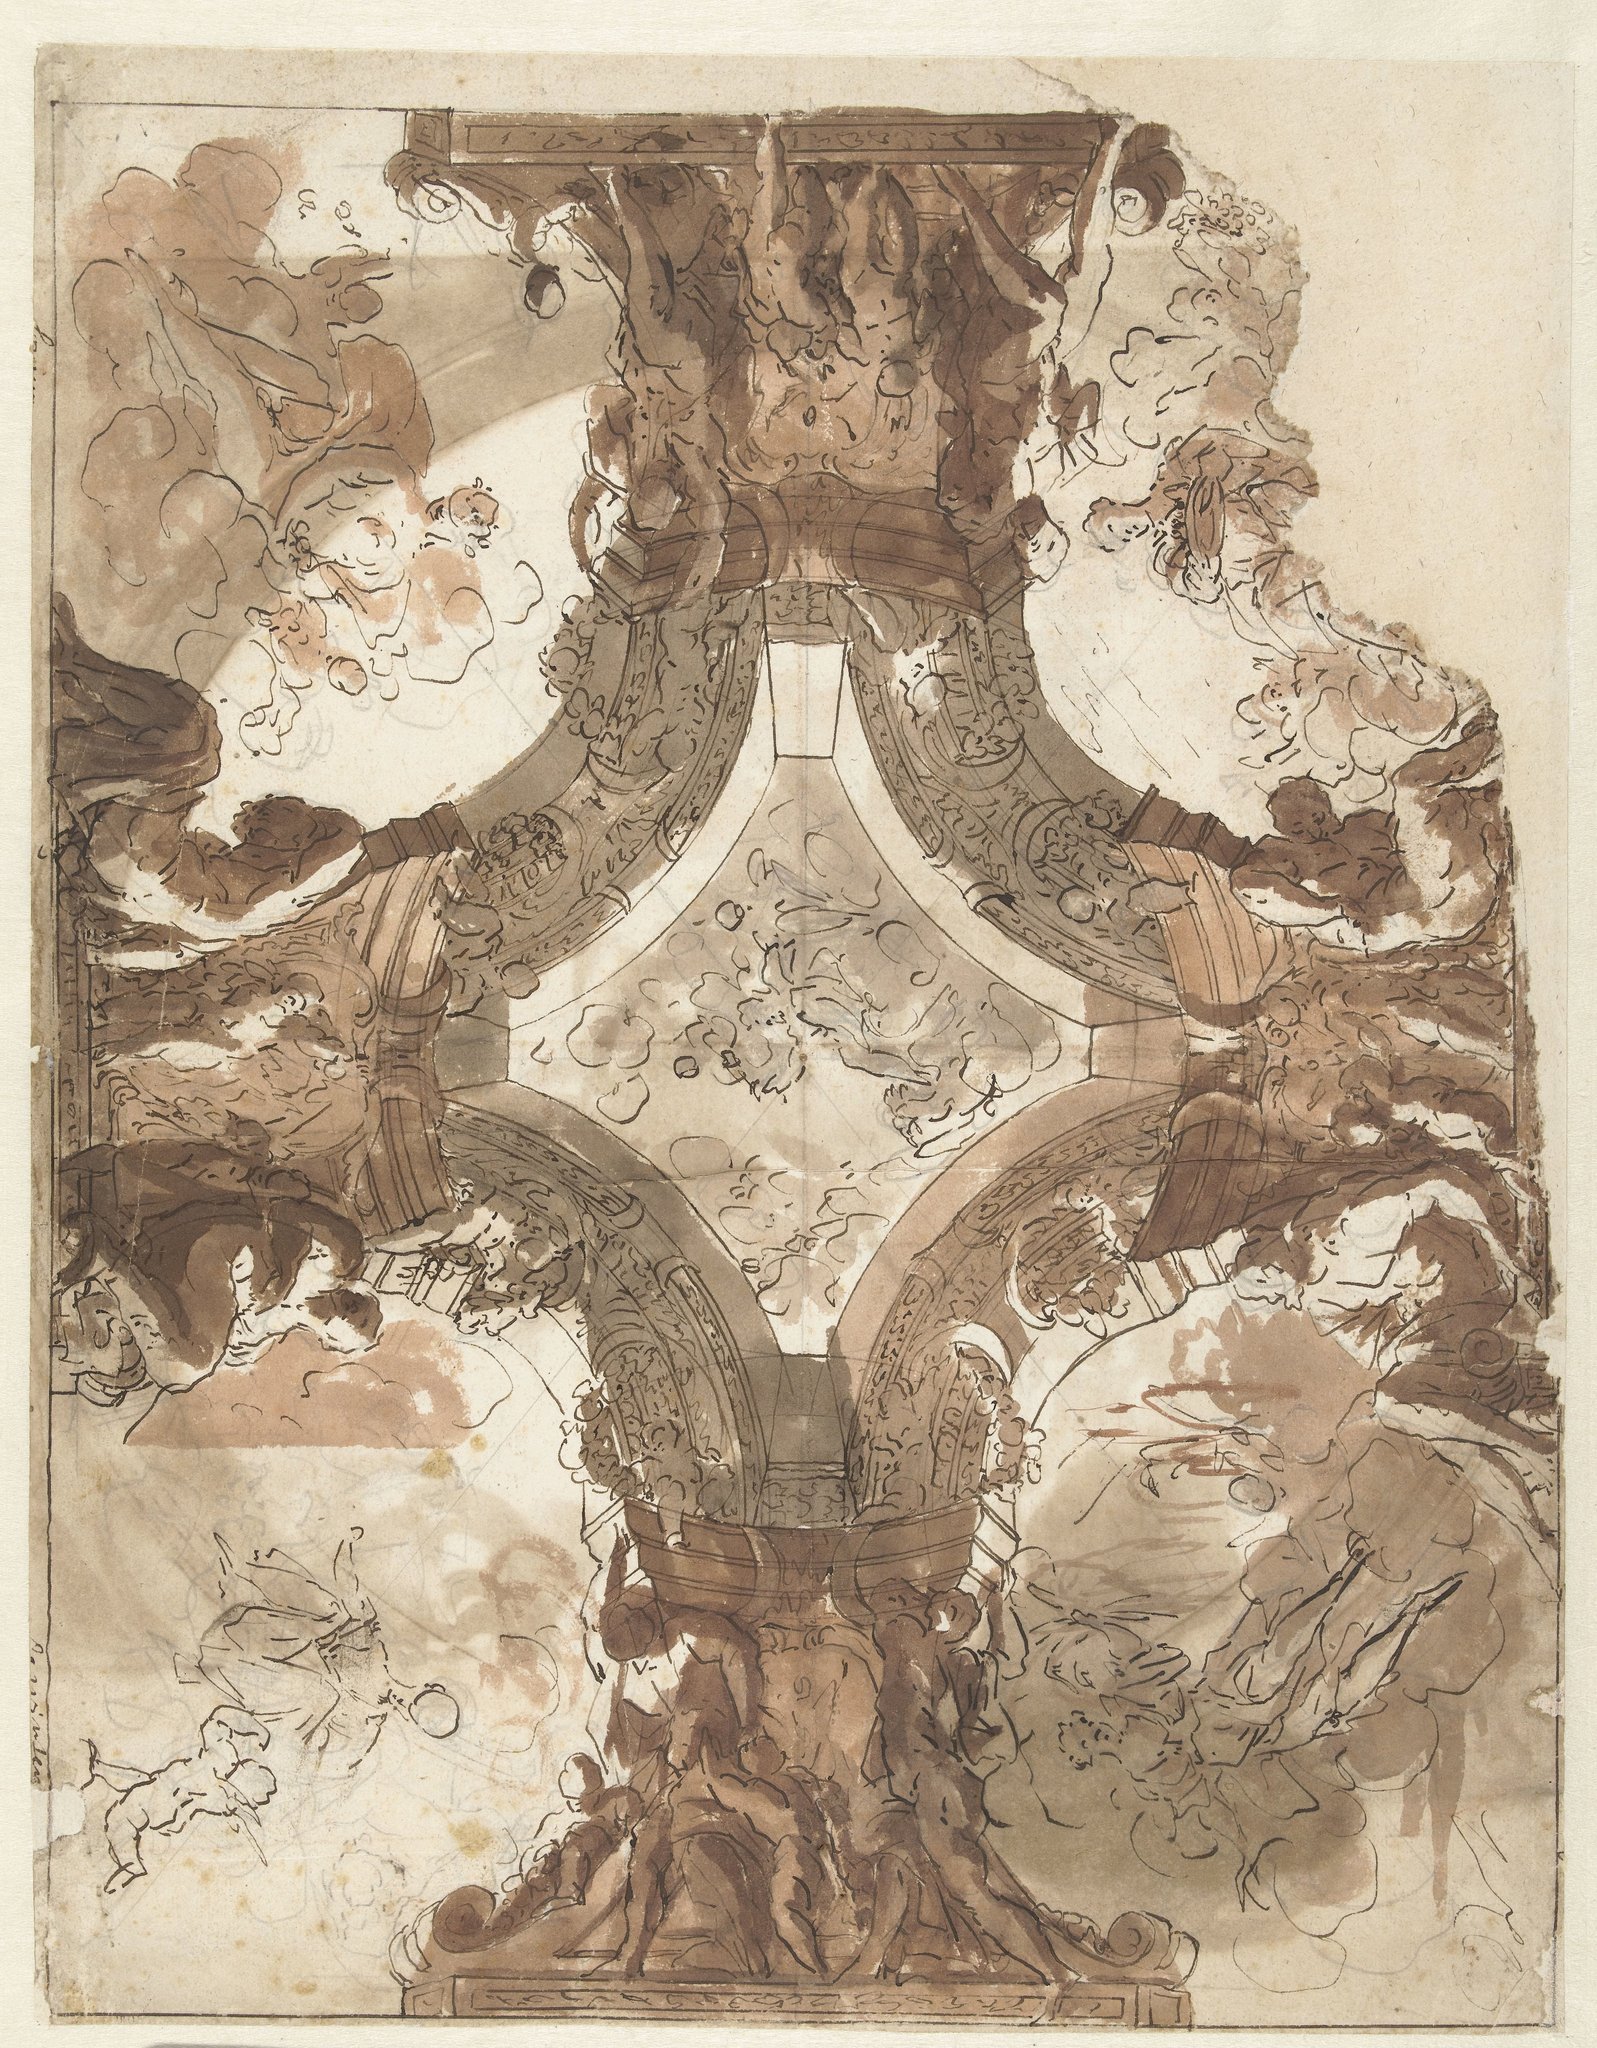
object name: drawing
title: Ontwerp voor een plafond met vijf vlakken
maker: mattheus terwesten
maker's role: draughtsman, painter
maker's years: 1670-1757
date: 1680-1757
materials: graphite, ink, paper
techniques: brush, pen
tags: (decorated) ceiling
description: Ontwerp voor een plafond met vijf vlakken, figuren schragen de kapitelen.